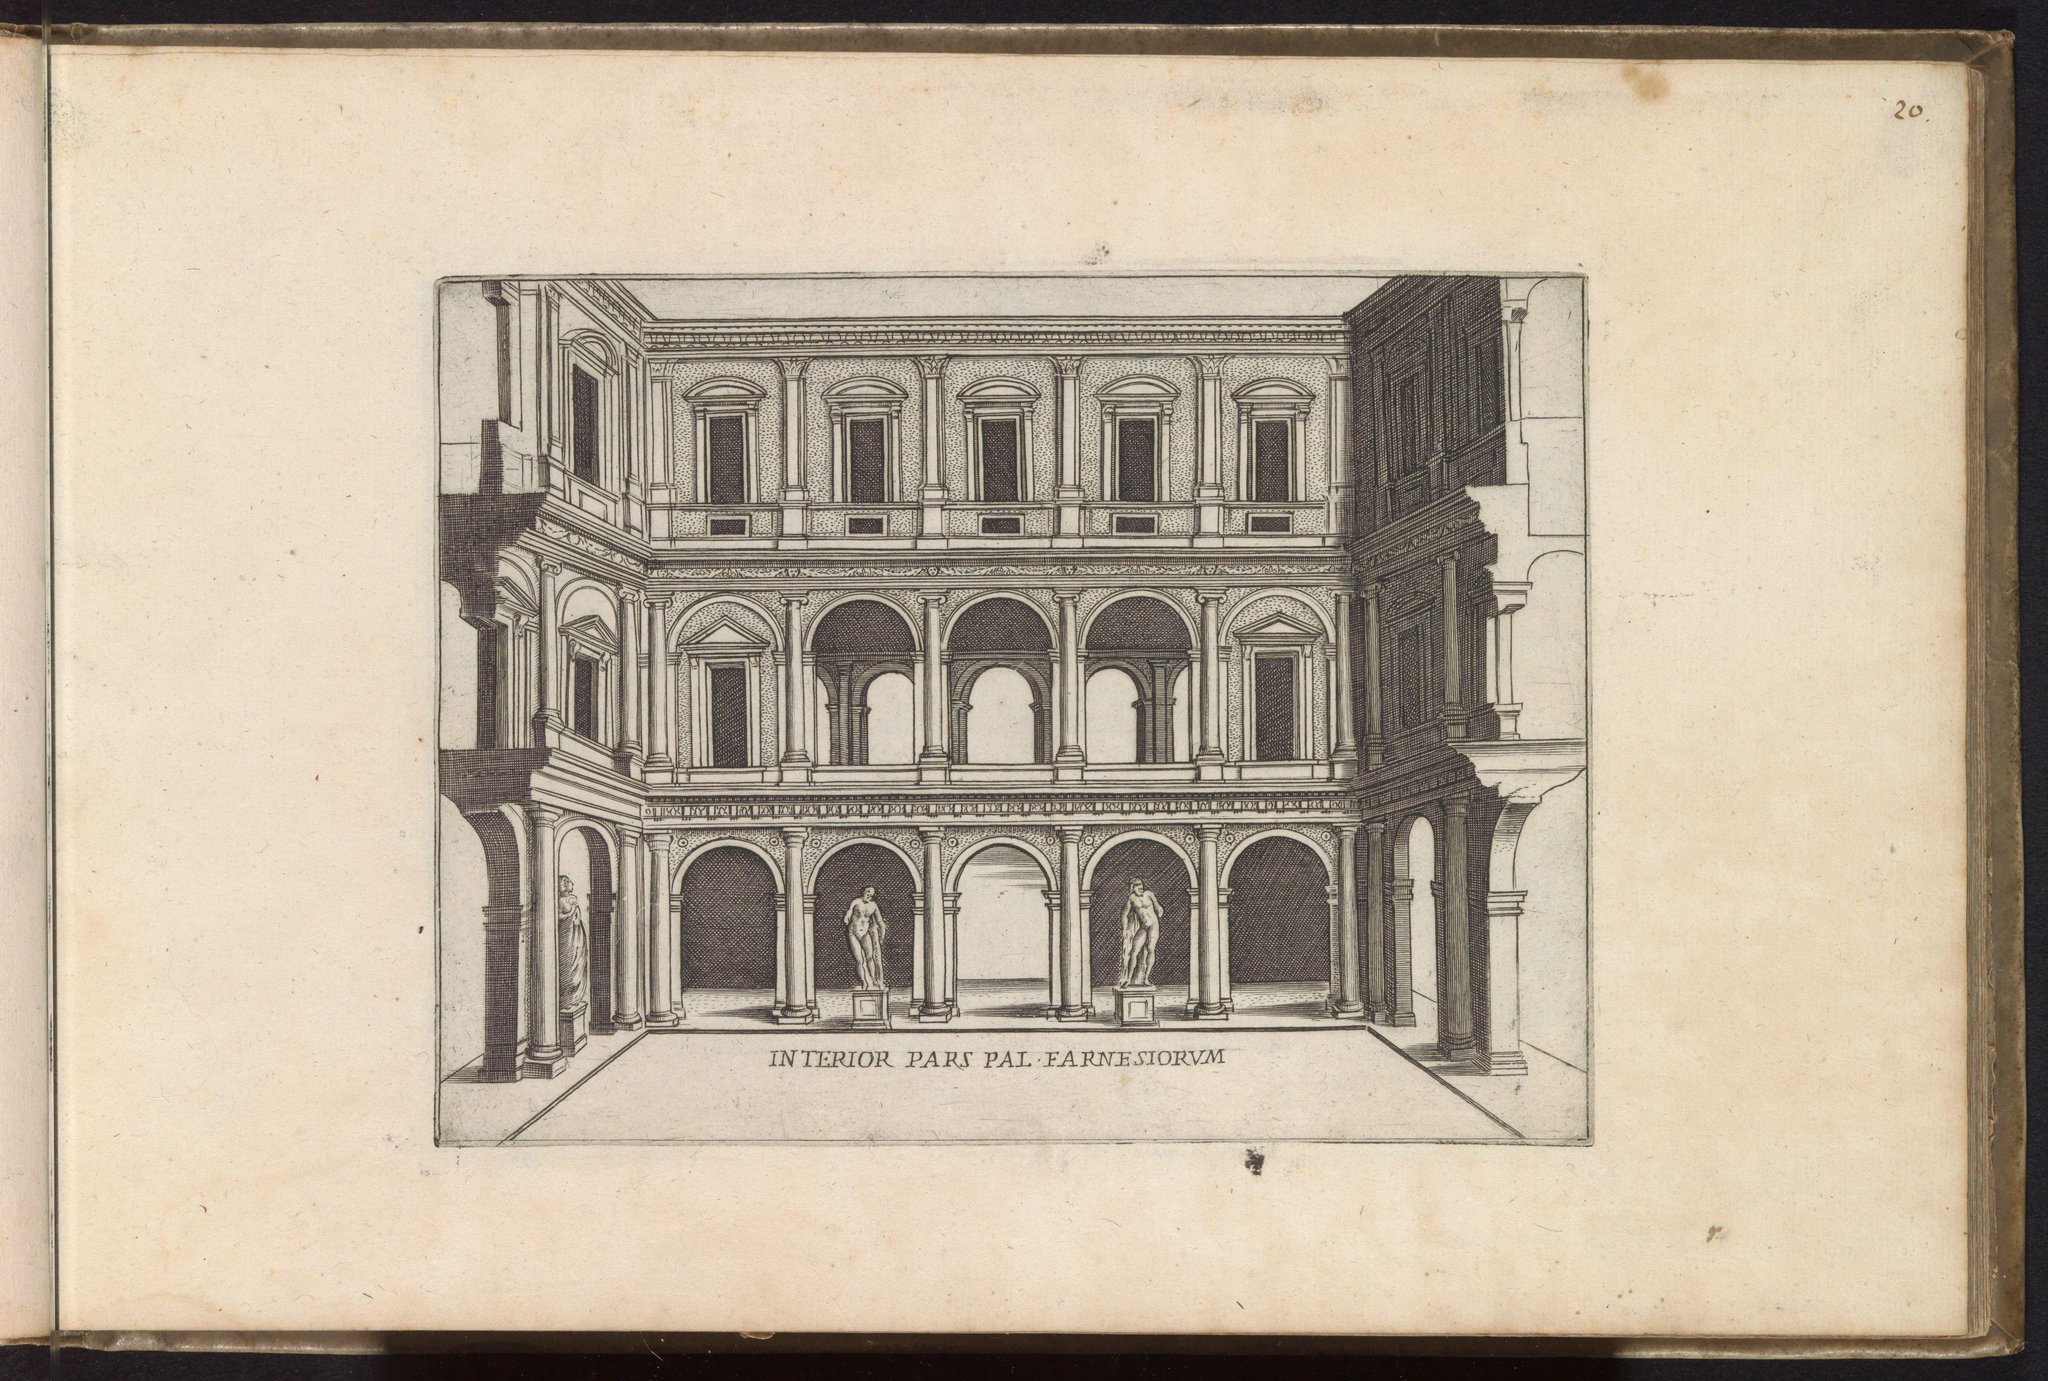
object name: album leaf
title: Binnenplaats van Palazzo Farnese te Rome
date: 1638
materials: paper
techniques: etching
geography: rome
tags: palace, façade (of house or building), inner court of palace or 'hôtel'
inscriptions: number: ‘20’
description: Prent maakt deel uit van een reeks prenten (+ titelprent) van beroemde gebouwen in Rome en elders.